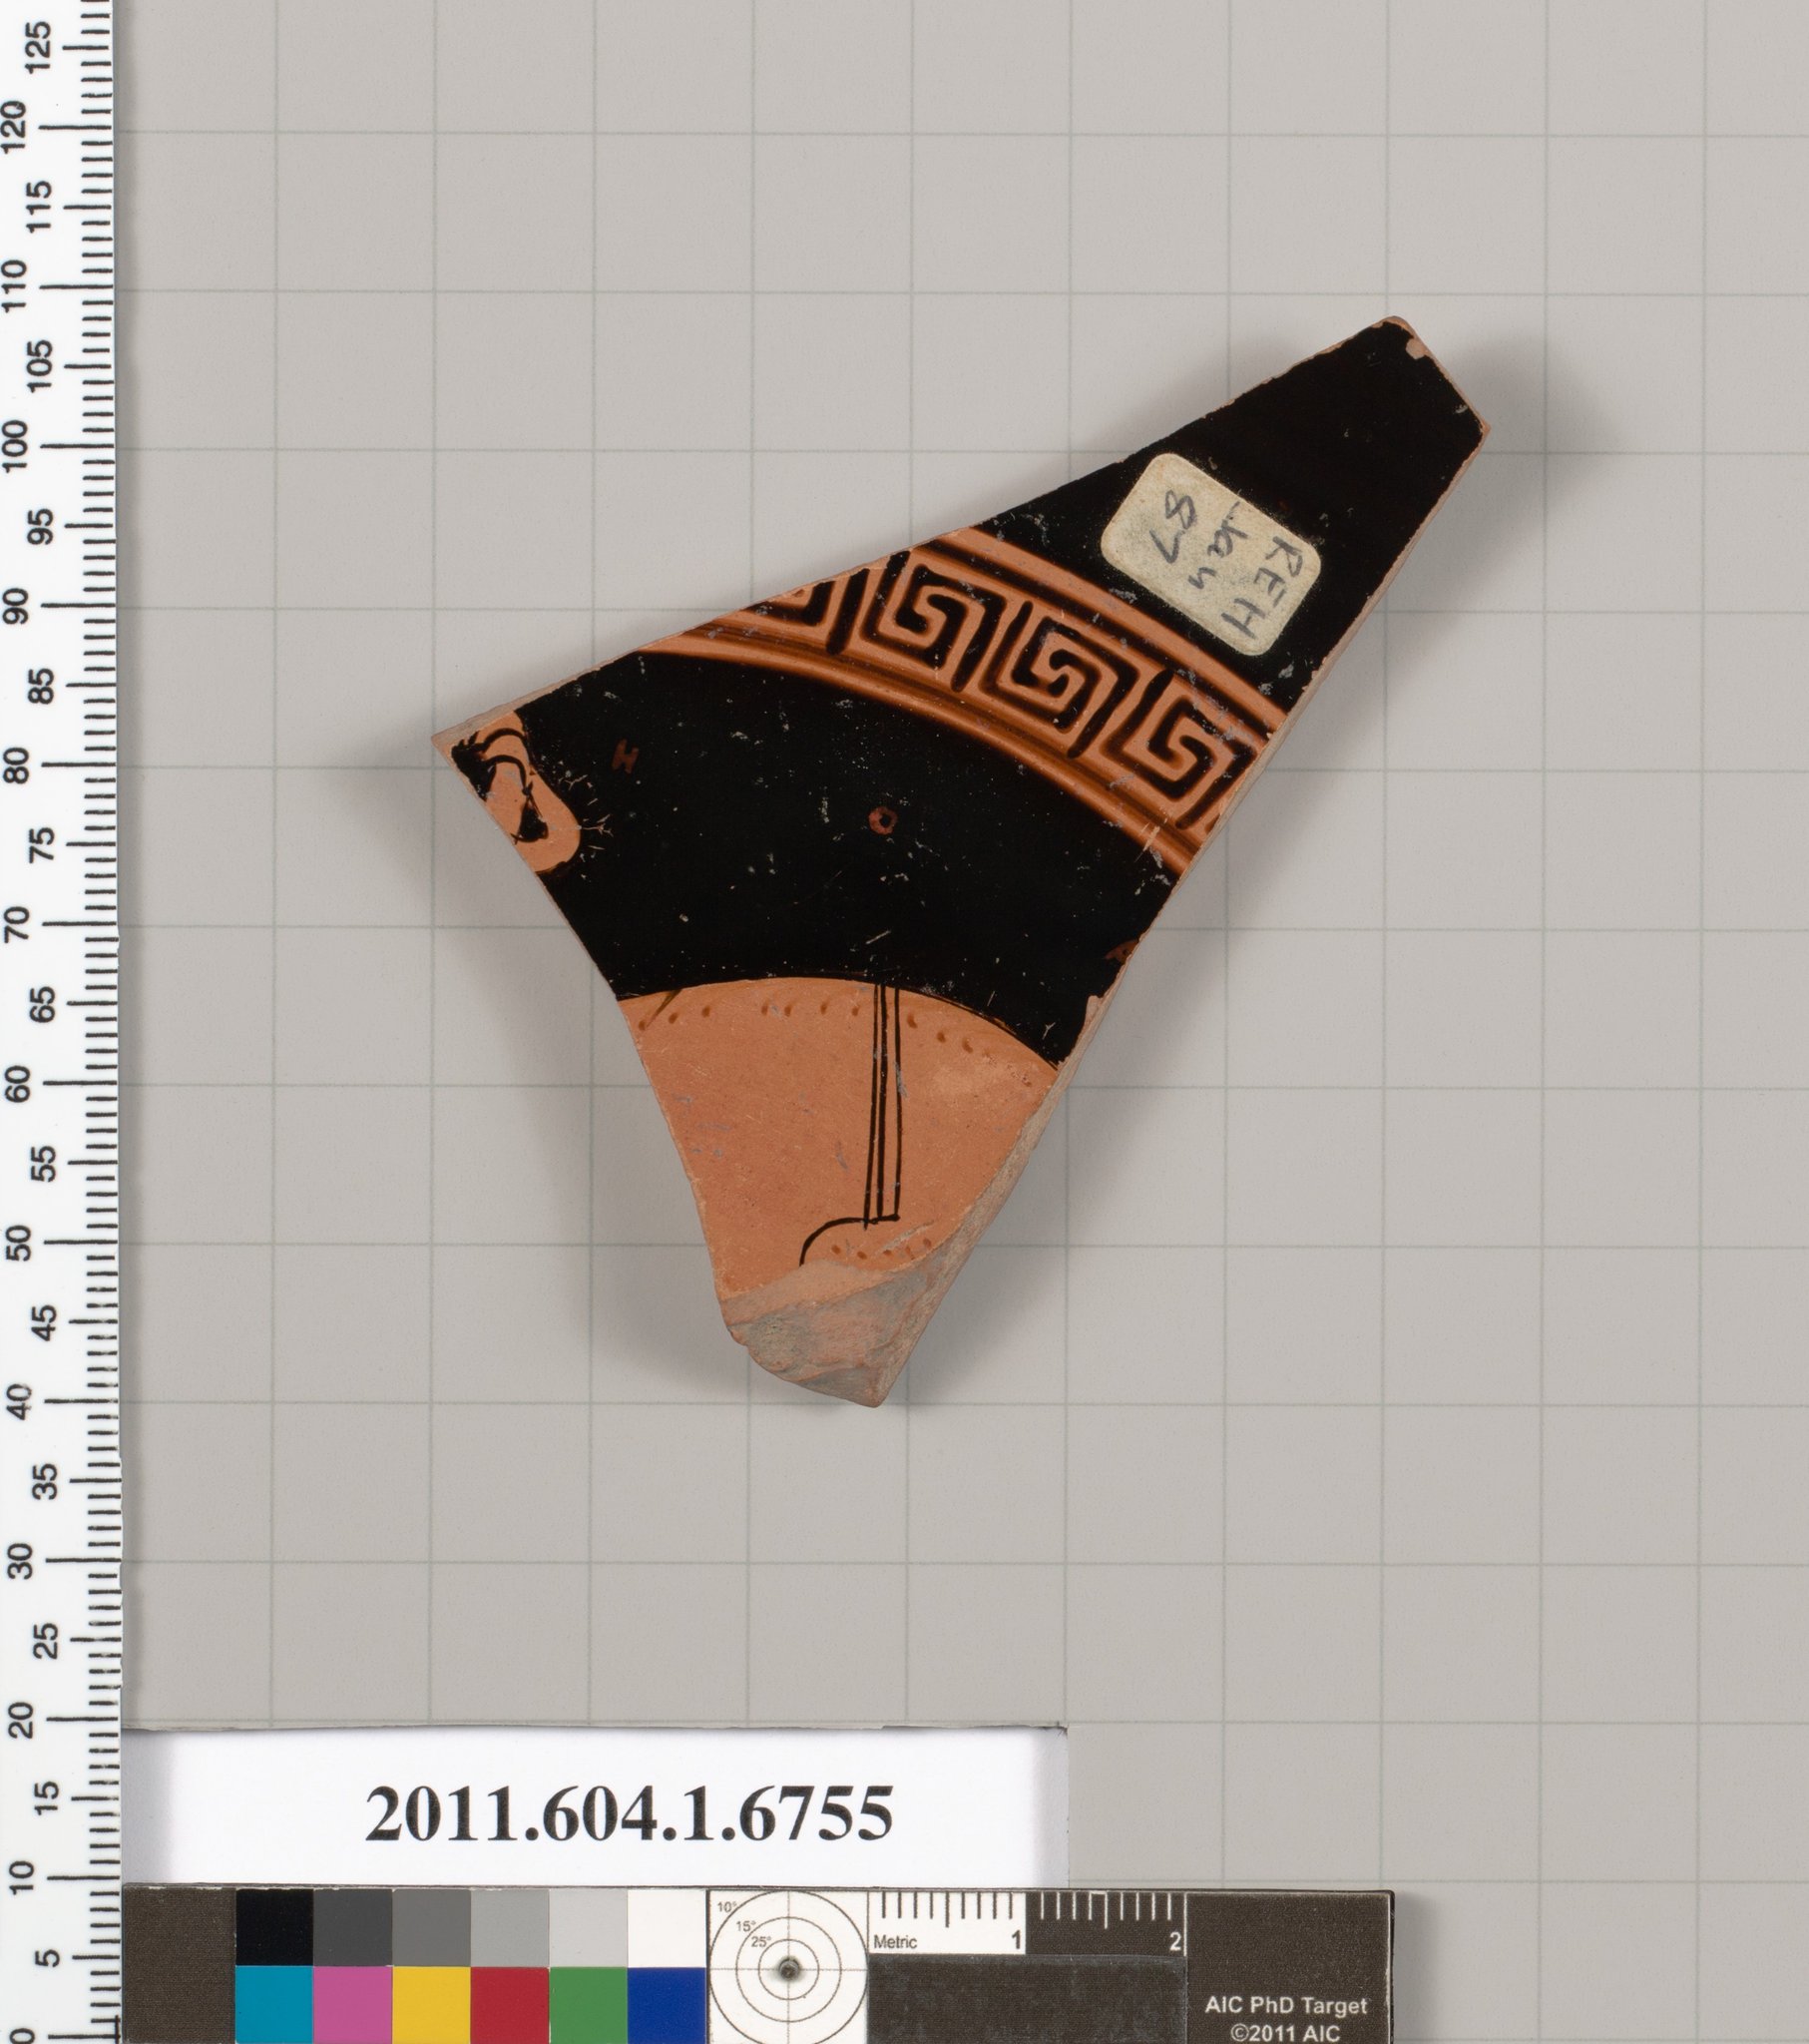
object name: kylix fragment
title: Terracotta fragment of a kylix (drinking cup)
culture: greek, attic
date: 490-470 BCE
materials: terracotta